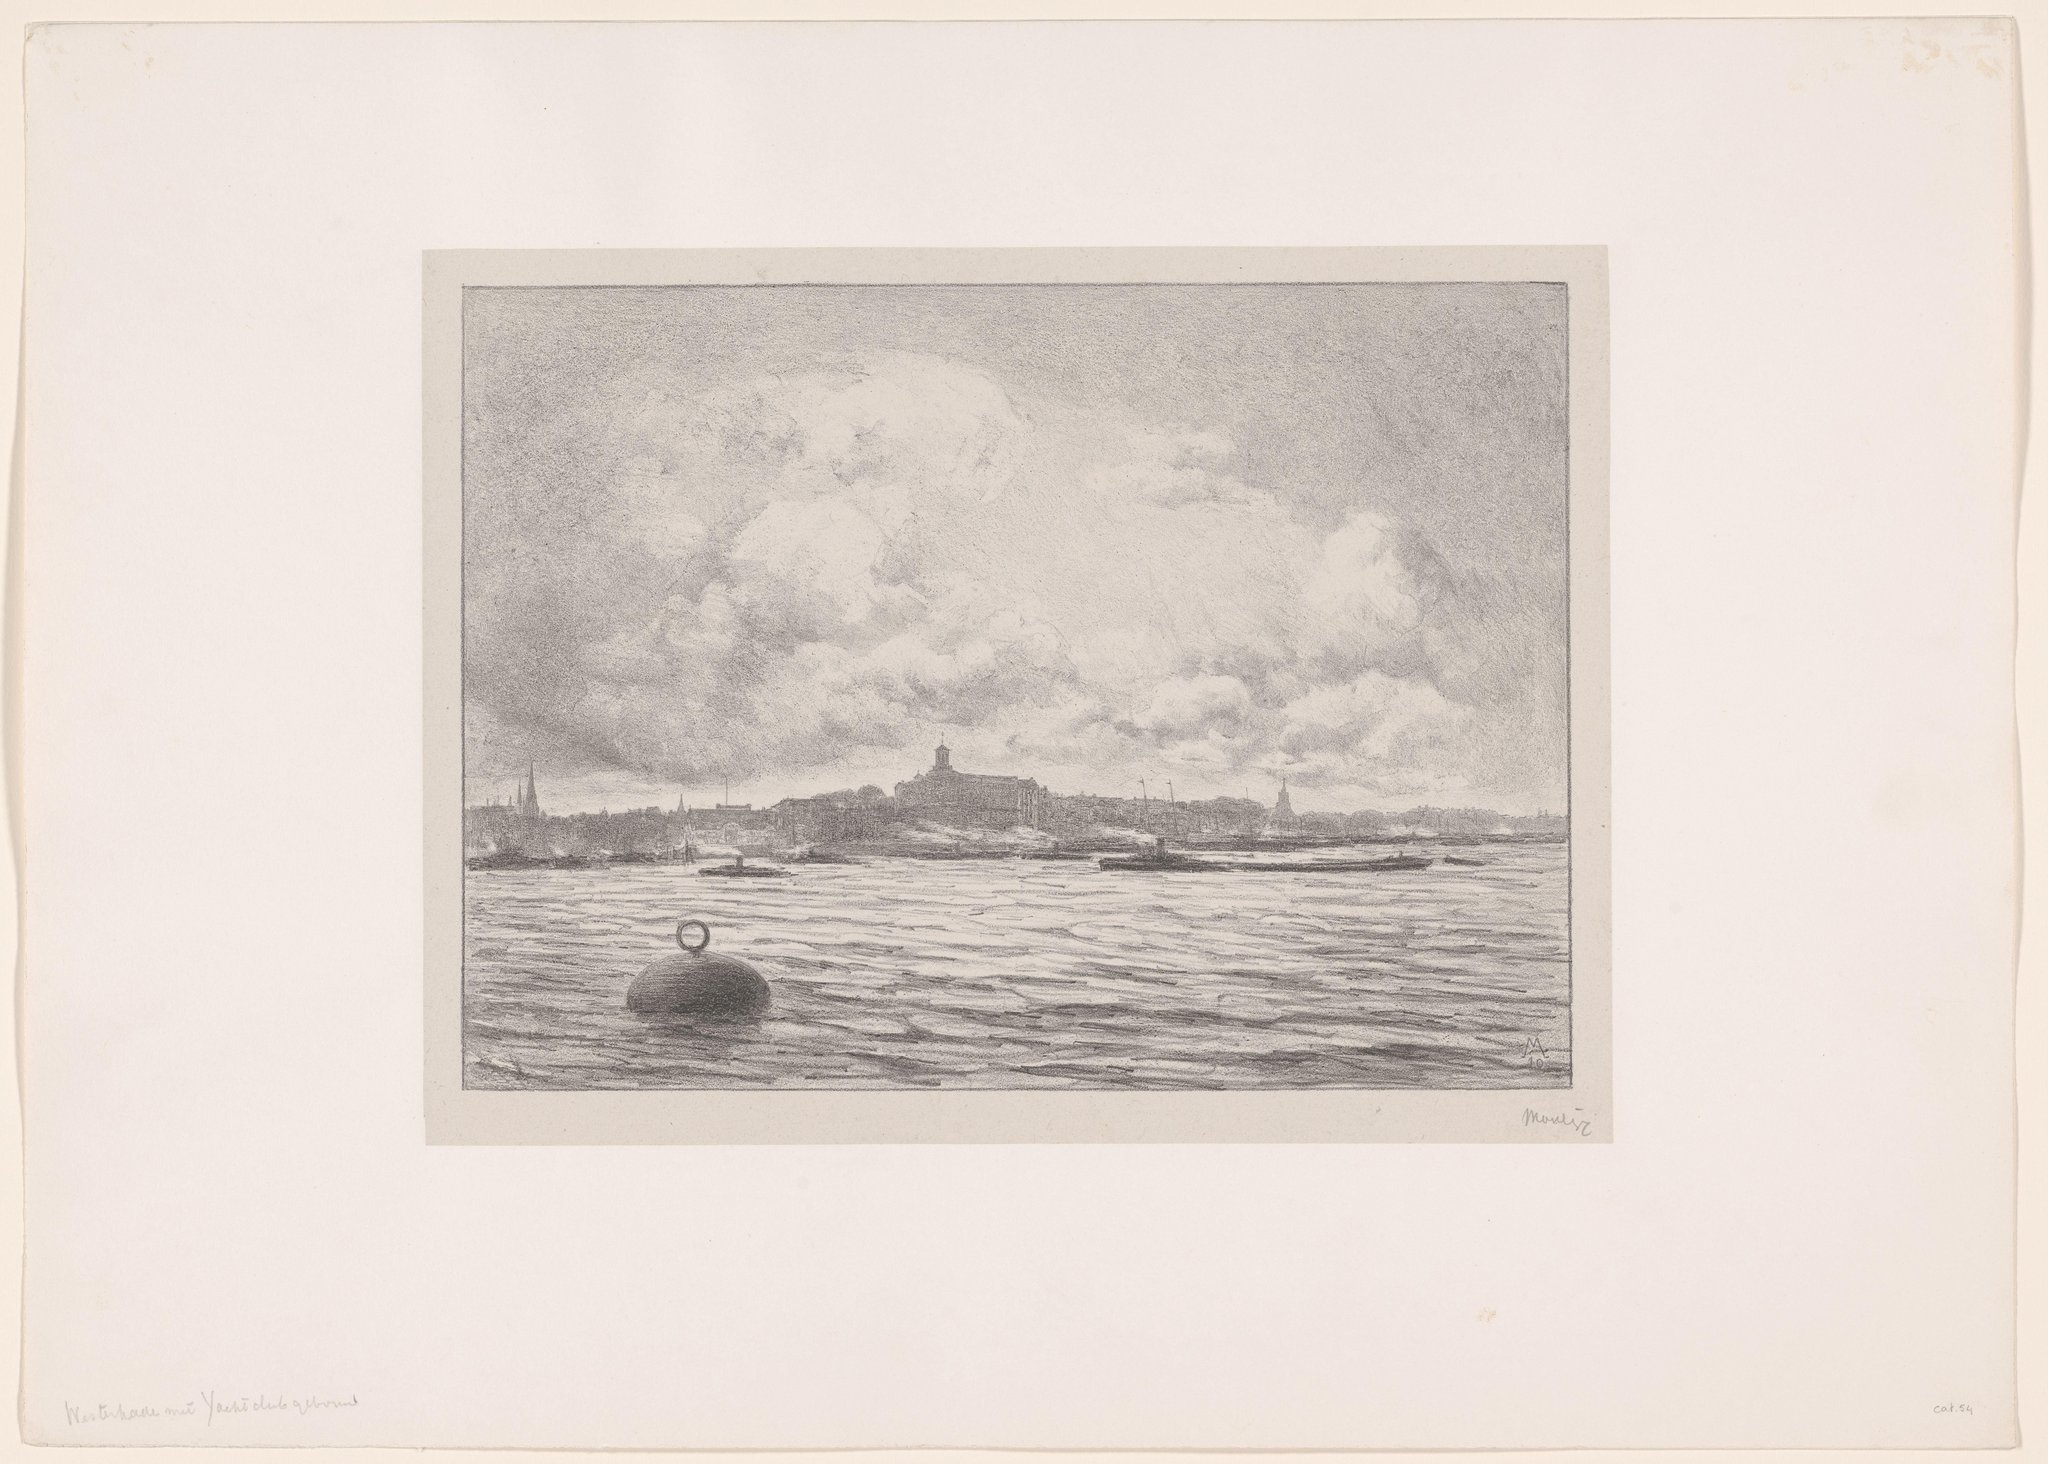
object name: print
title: De Maas in Rotterdam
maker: simon moulijn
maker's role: draughtsman, print maker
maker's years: 1866-1948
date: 1910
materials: paper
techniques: lithograph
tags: prospect of city, town panorama, silhouette of city, rotterdam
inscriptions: collector's mark: Lugt 2228, annotation: ‘Westerkade met Yaghtclubgebouw’